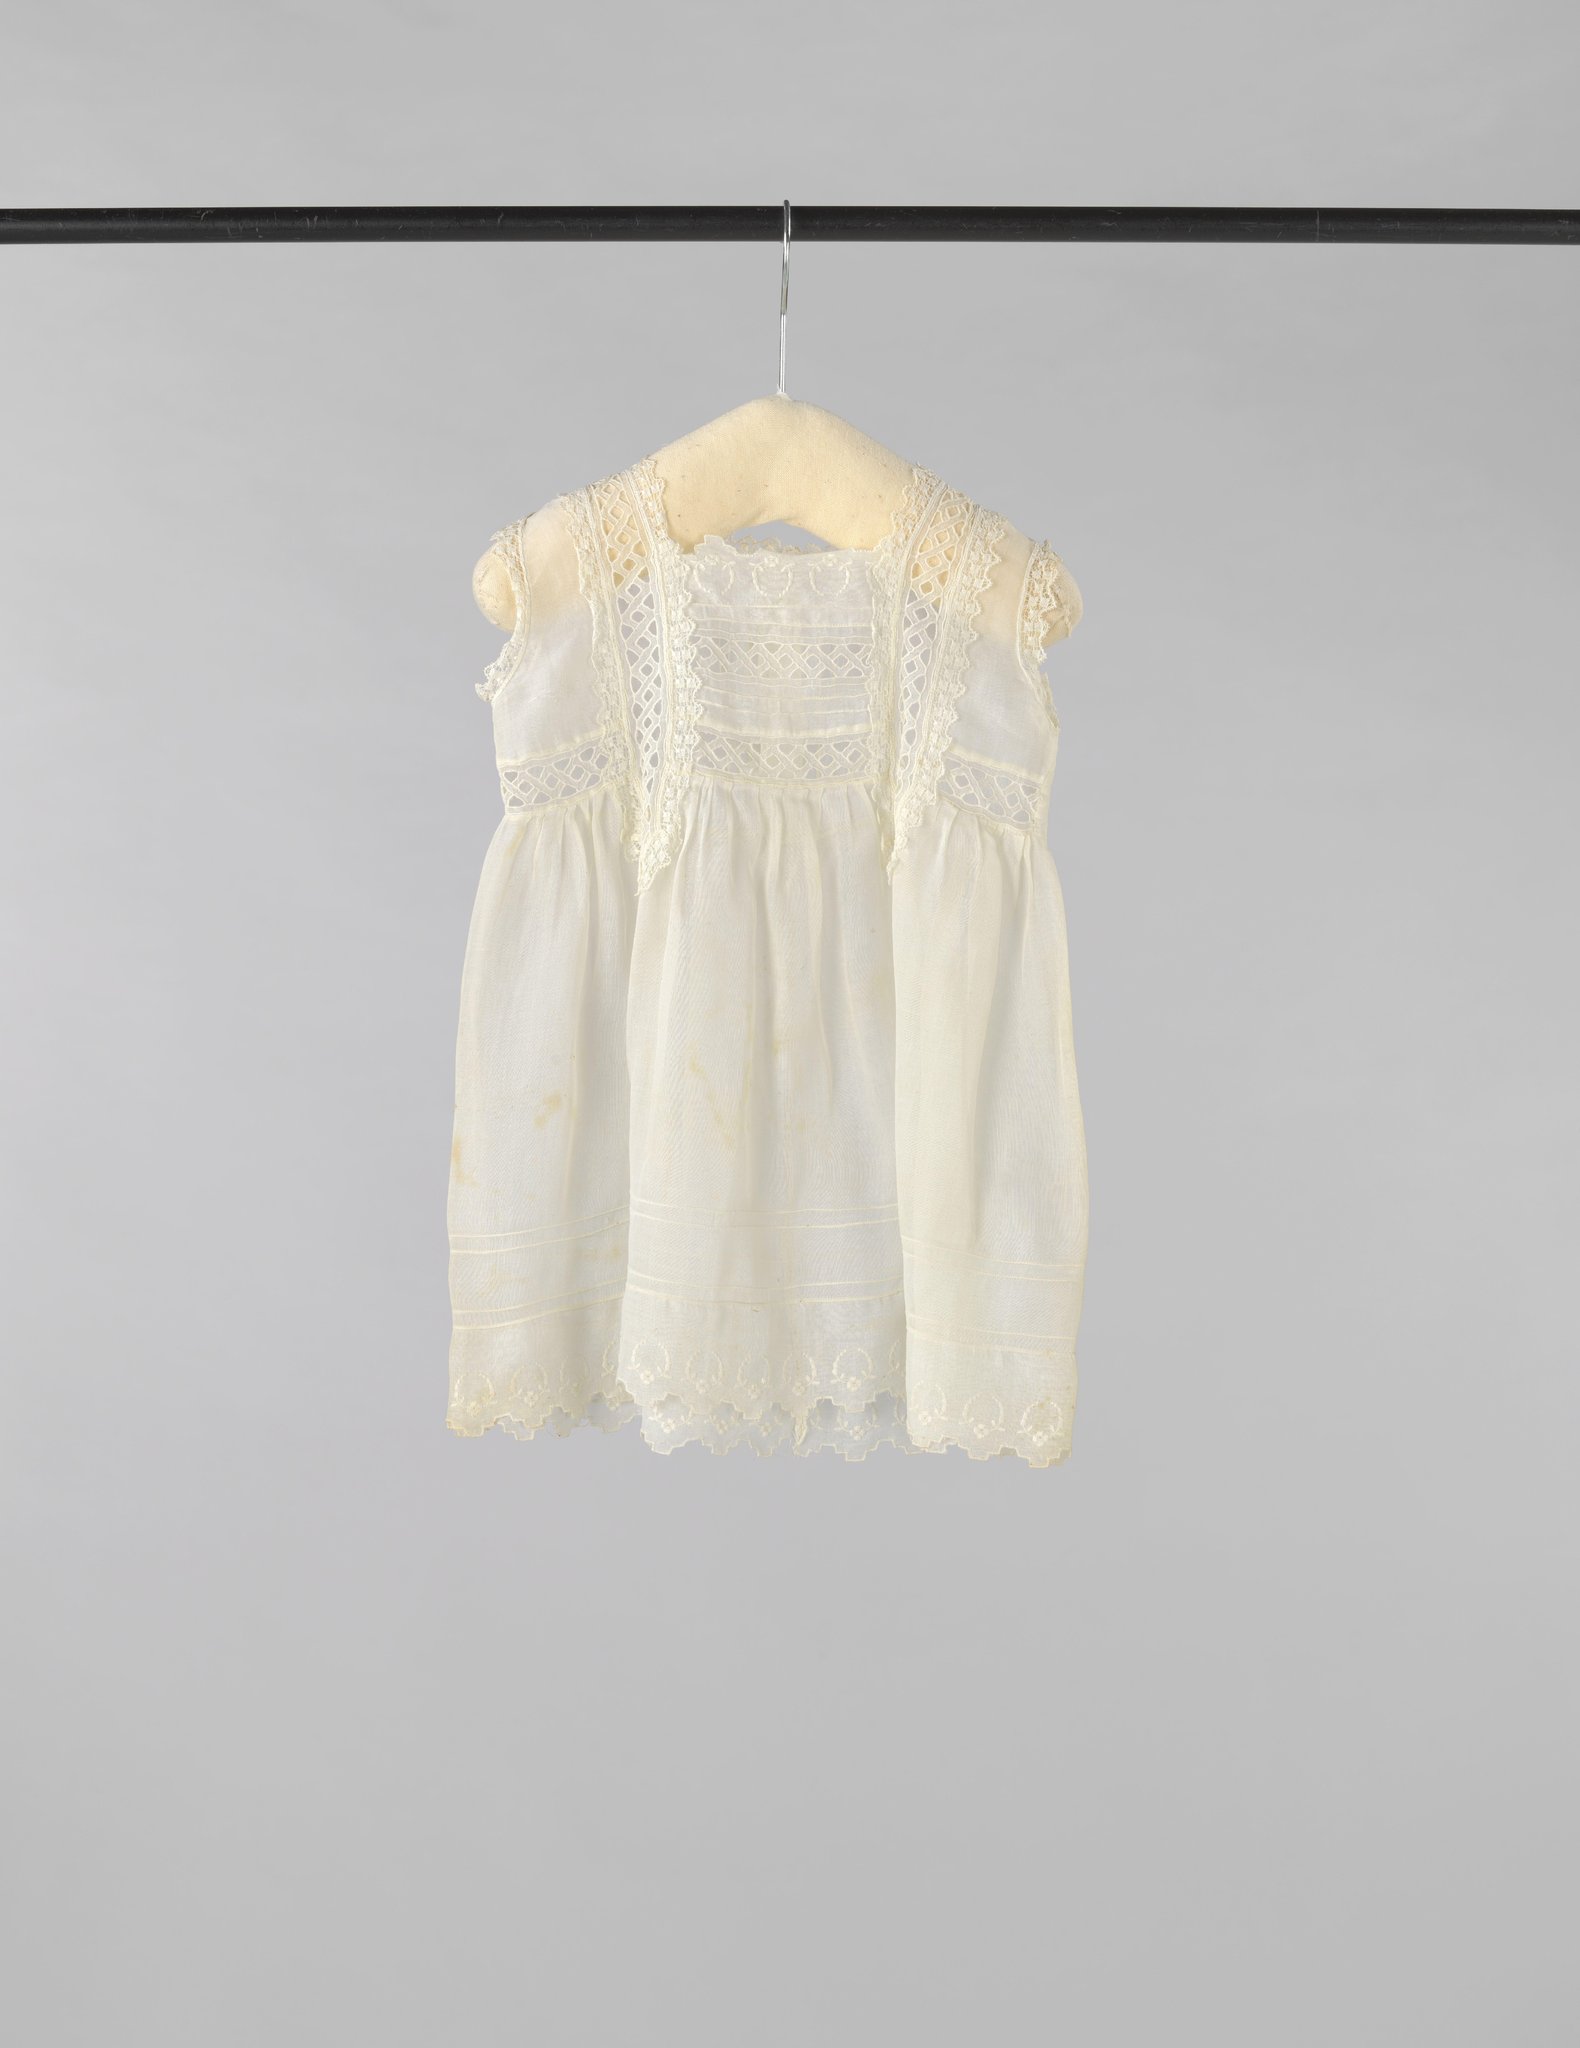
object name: robe, japon, jurk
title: Mouwloze kinderjurk van wit linnen (?), versierd met wit borduurwerk, oprijgen, ajour tussenzetsels met ruitpatroon en kantranden; hoekige gefestonneerde zoom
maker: Anonymous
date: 1922-1926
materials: linen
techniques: embroidered, embroidery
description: Mouwloze kinderjurk van wit linnen (?), versierd met wit borduurwerk, oprijgen, ajour tussenzetsels met ruitpatroon en kantranden; hoekige gefestonneerde zoom.